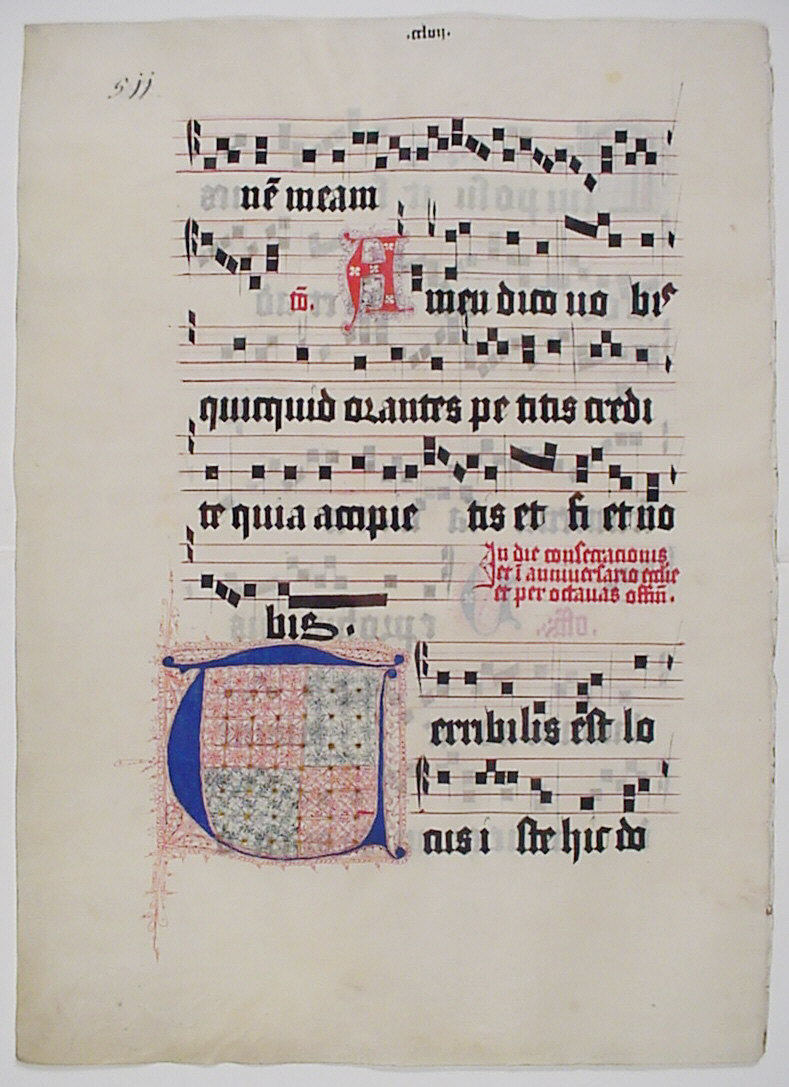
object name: gradual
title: Manuscript Leaf with Initial T, from a Gradual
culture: german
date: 1426-1450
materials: ink, metal leaf, parchment, paint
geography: germany